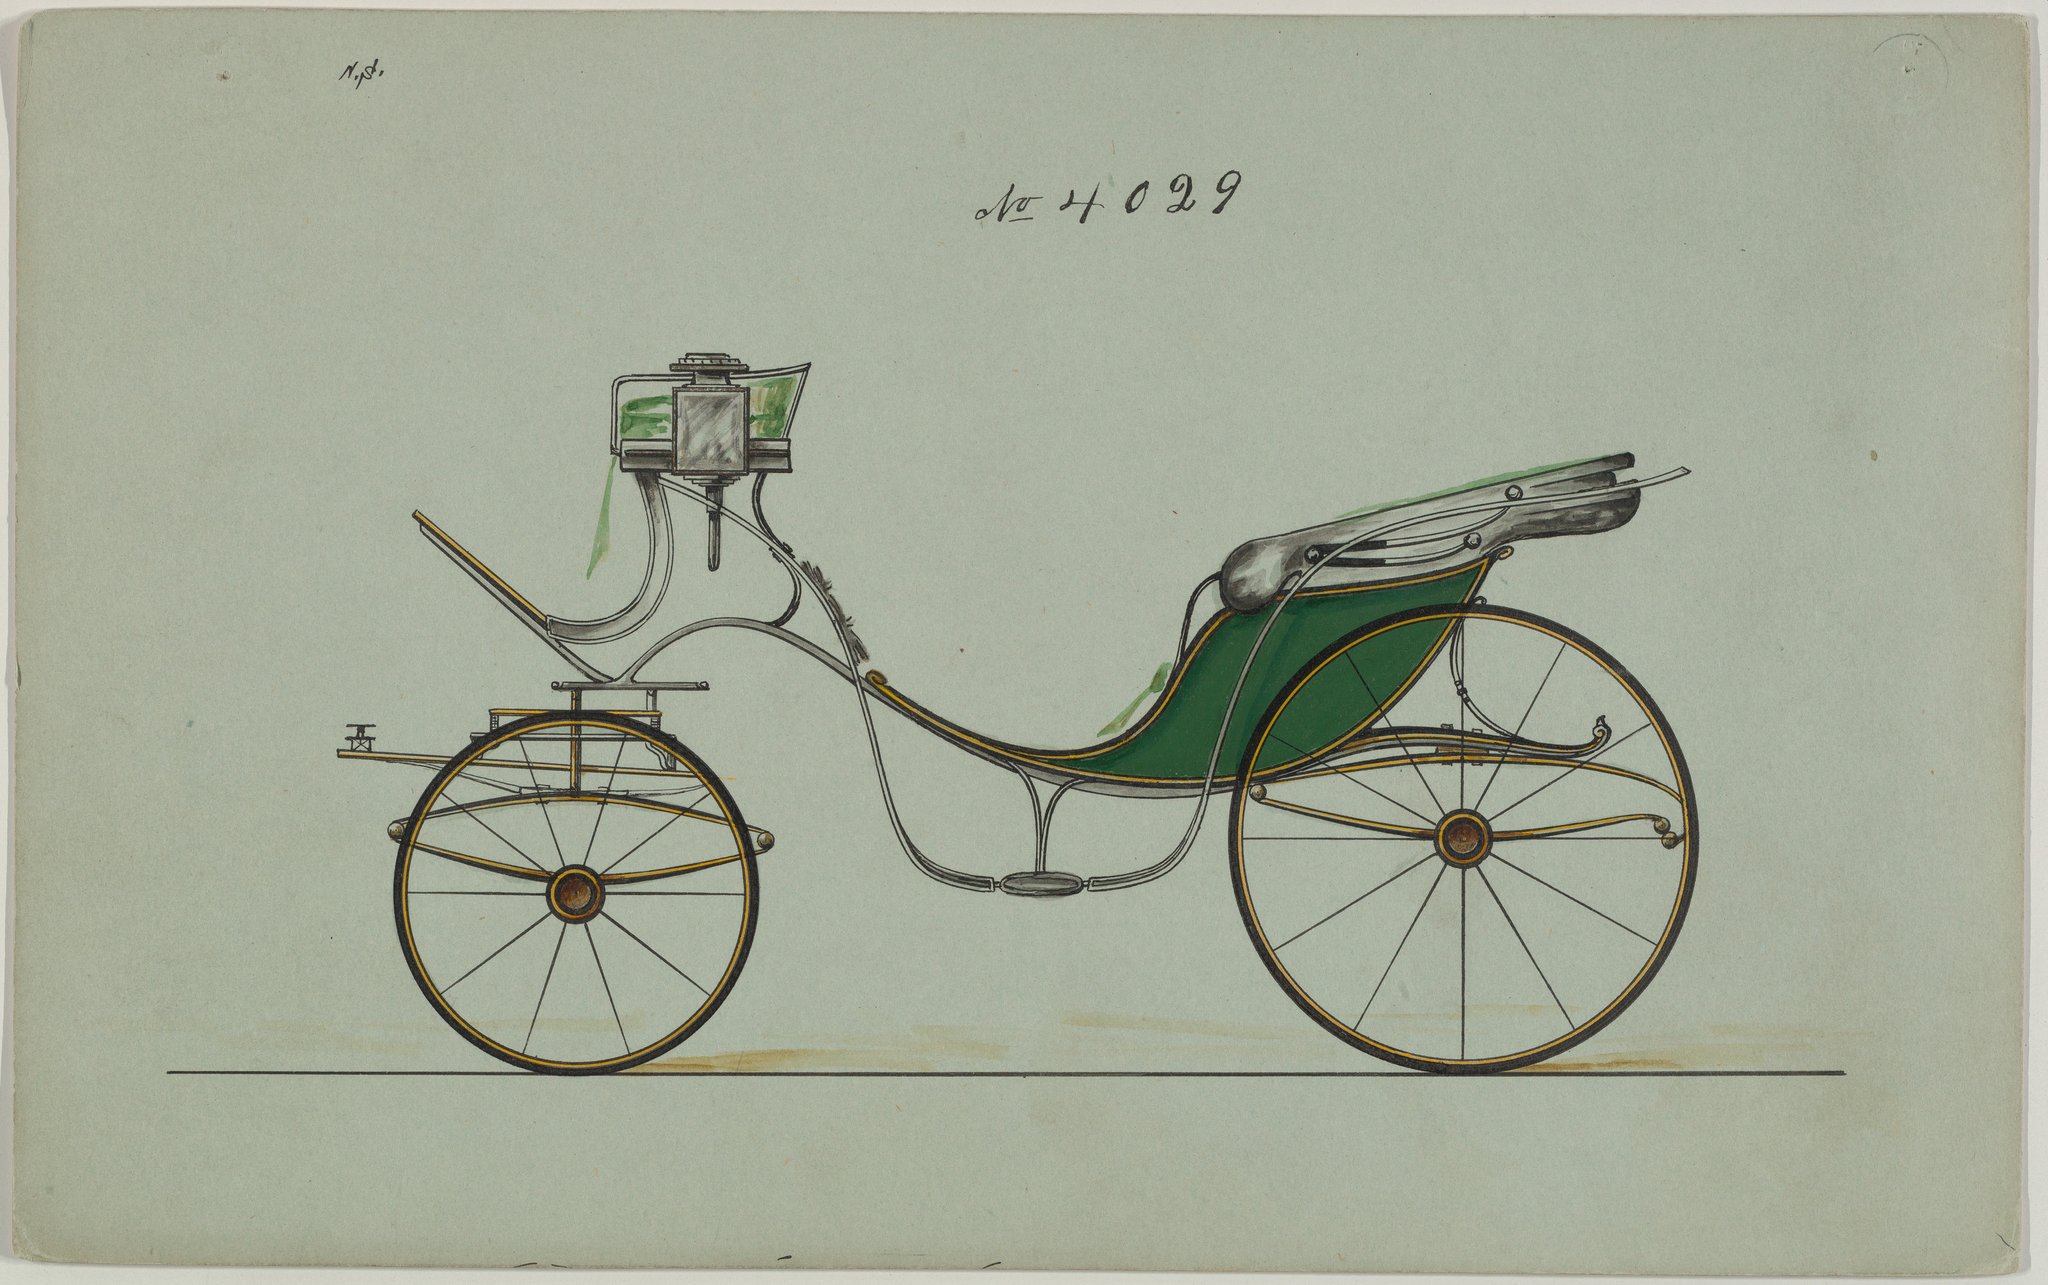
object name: drawing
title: Design for Cabriolet or Victoria, no. 4029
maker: brewster & co.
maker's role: manufacturer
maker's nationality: american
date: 1888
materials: gouache, gum arabic, ink, watercolor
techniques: pen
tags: carriages